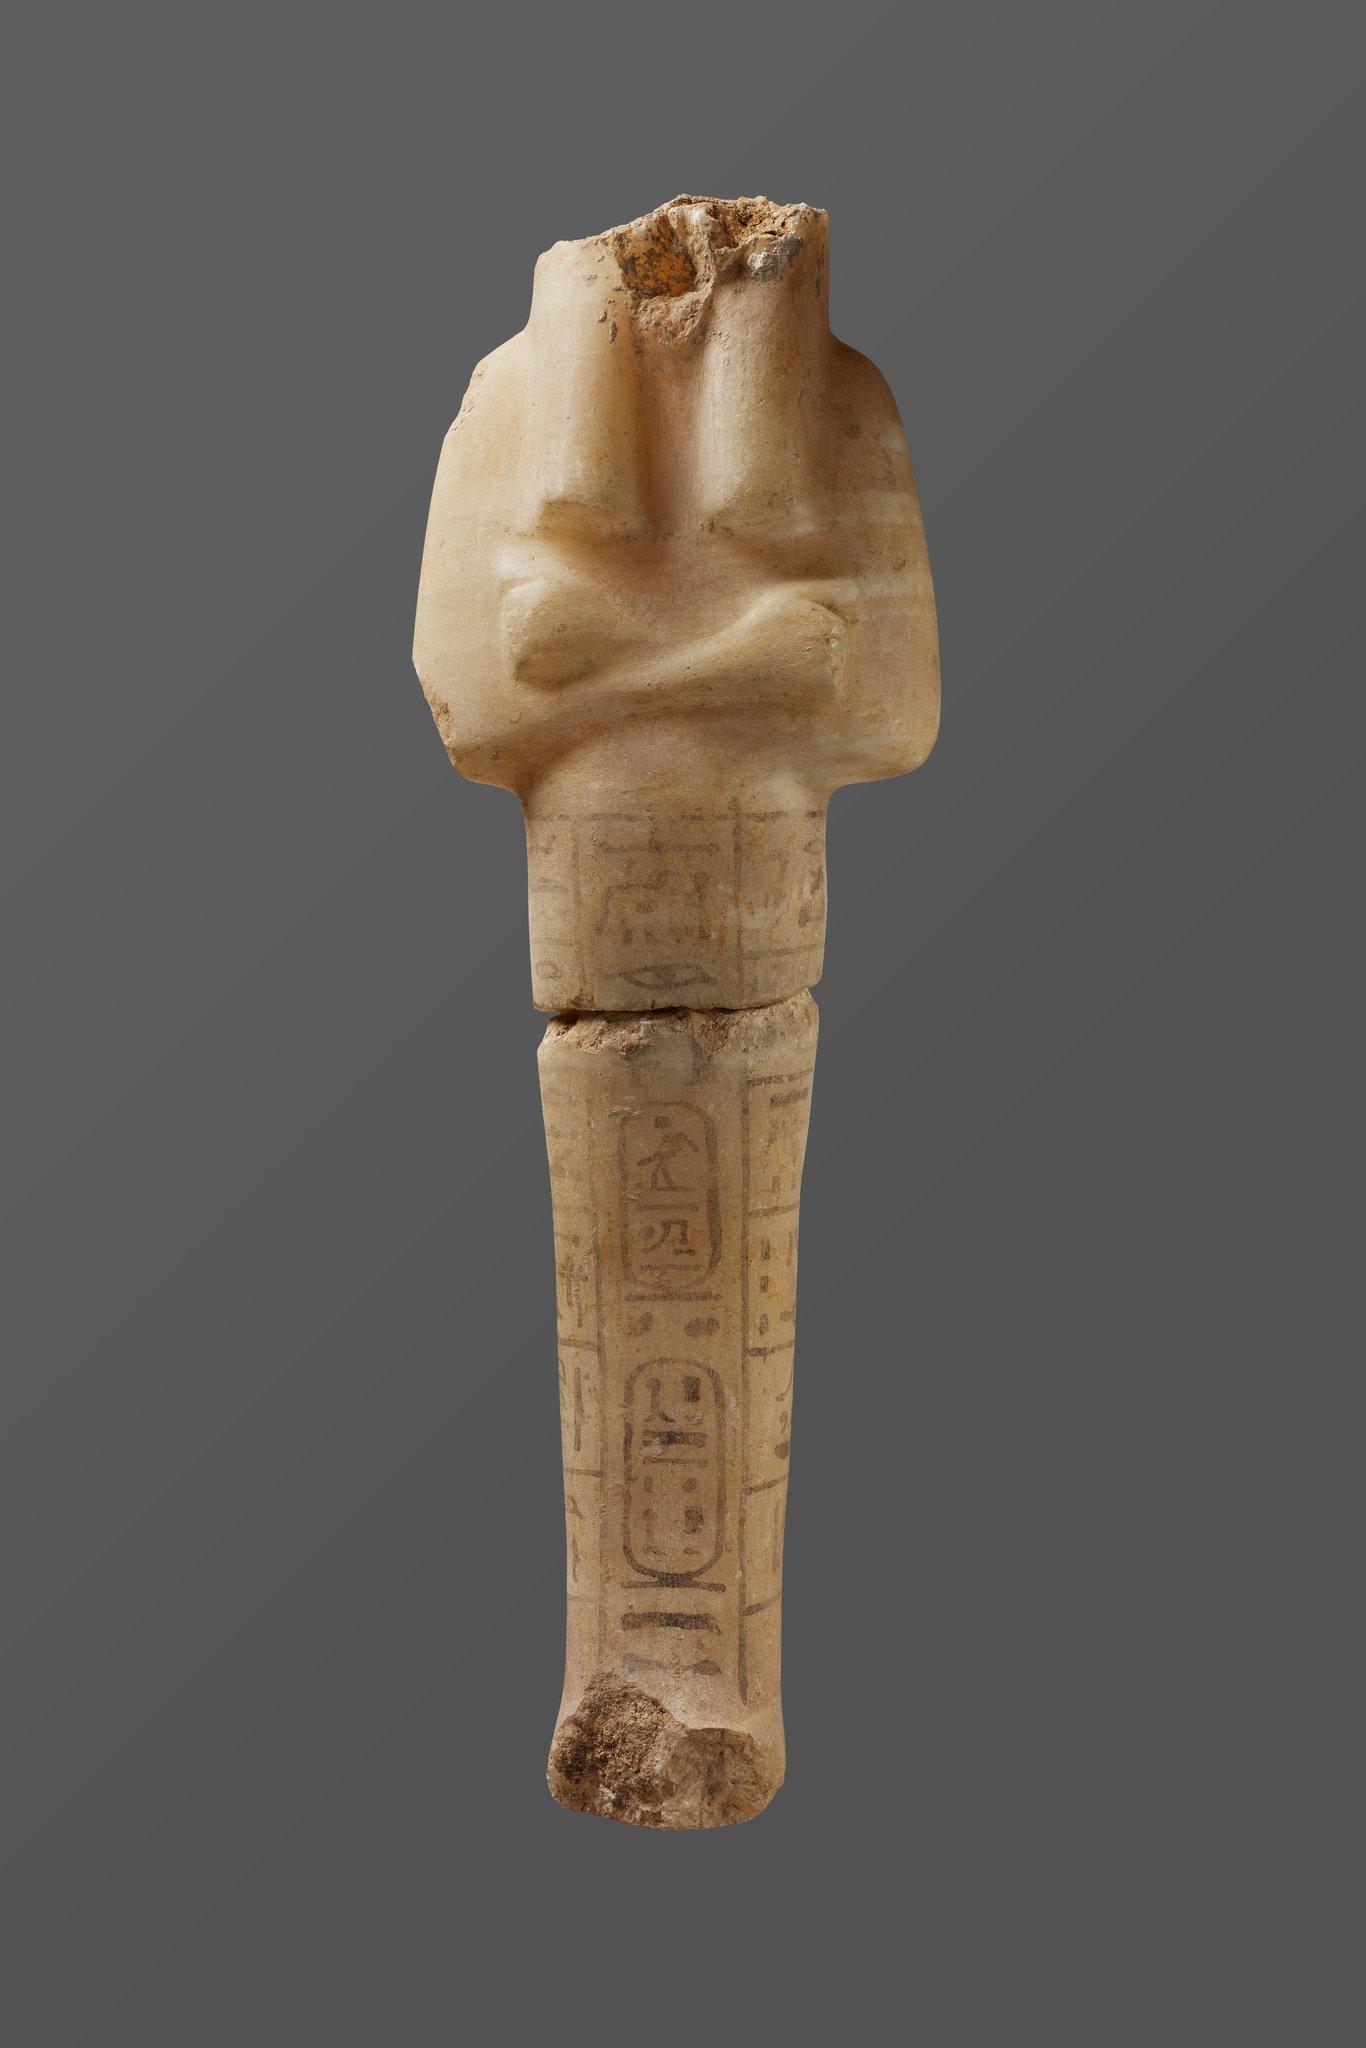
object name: shabti, siptah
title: Shabti of Siptah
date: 1194-1188 BCE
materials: stone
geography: egypt